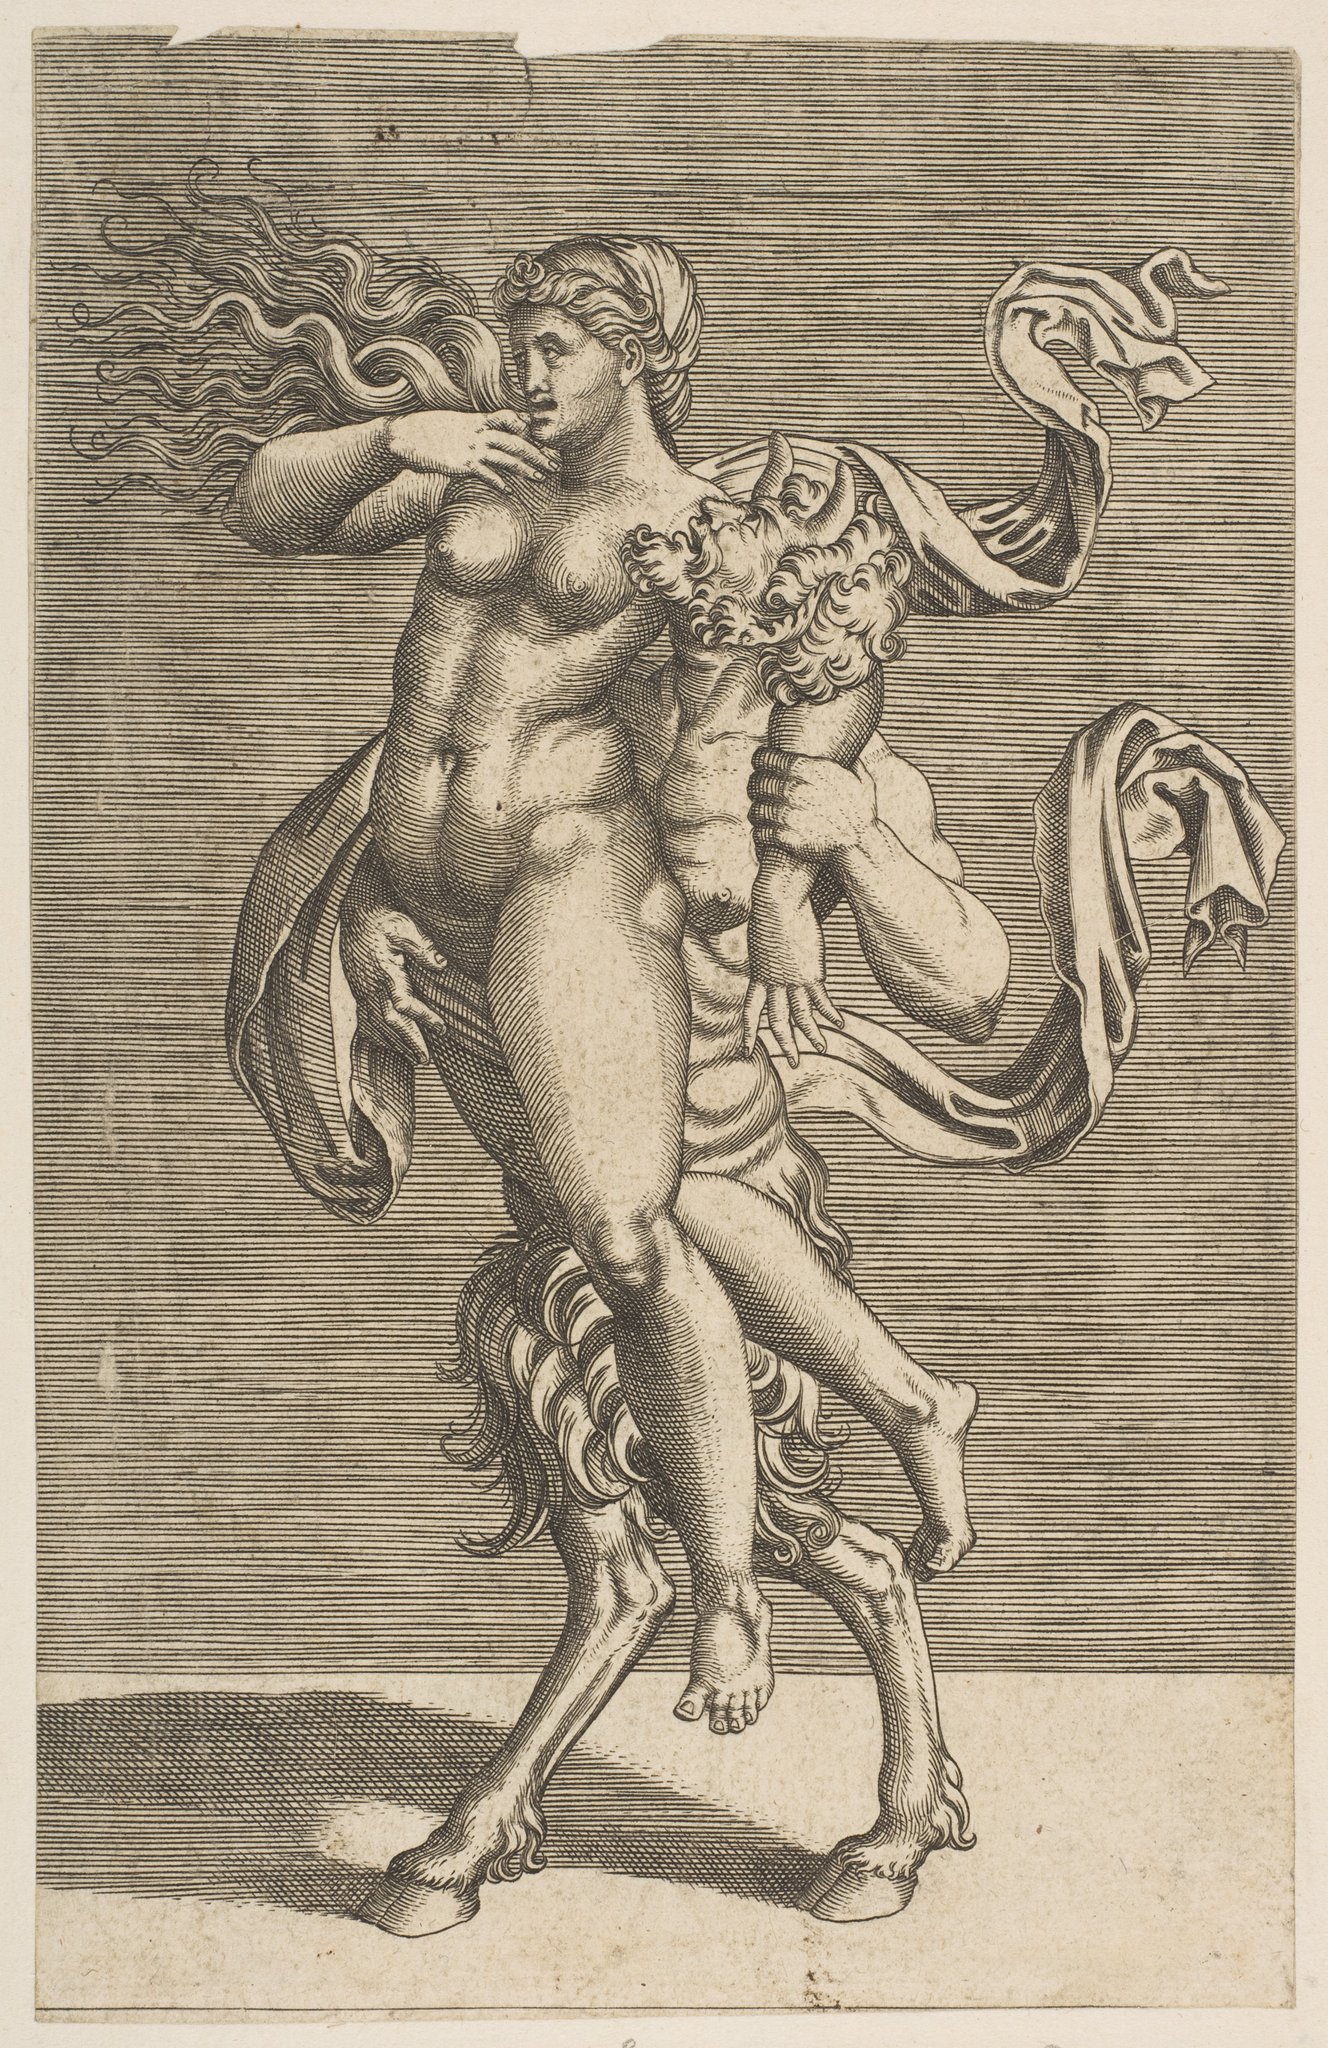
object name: print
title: Satyr carrying a nymph restraining her right arm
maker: anonymous, italian, 16th to early 17th century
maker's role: artist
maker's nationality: italian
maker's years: 1500-1640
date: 1515-1600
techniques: engraving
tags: nymphs,satyrs